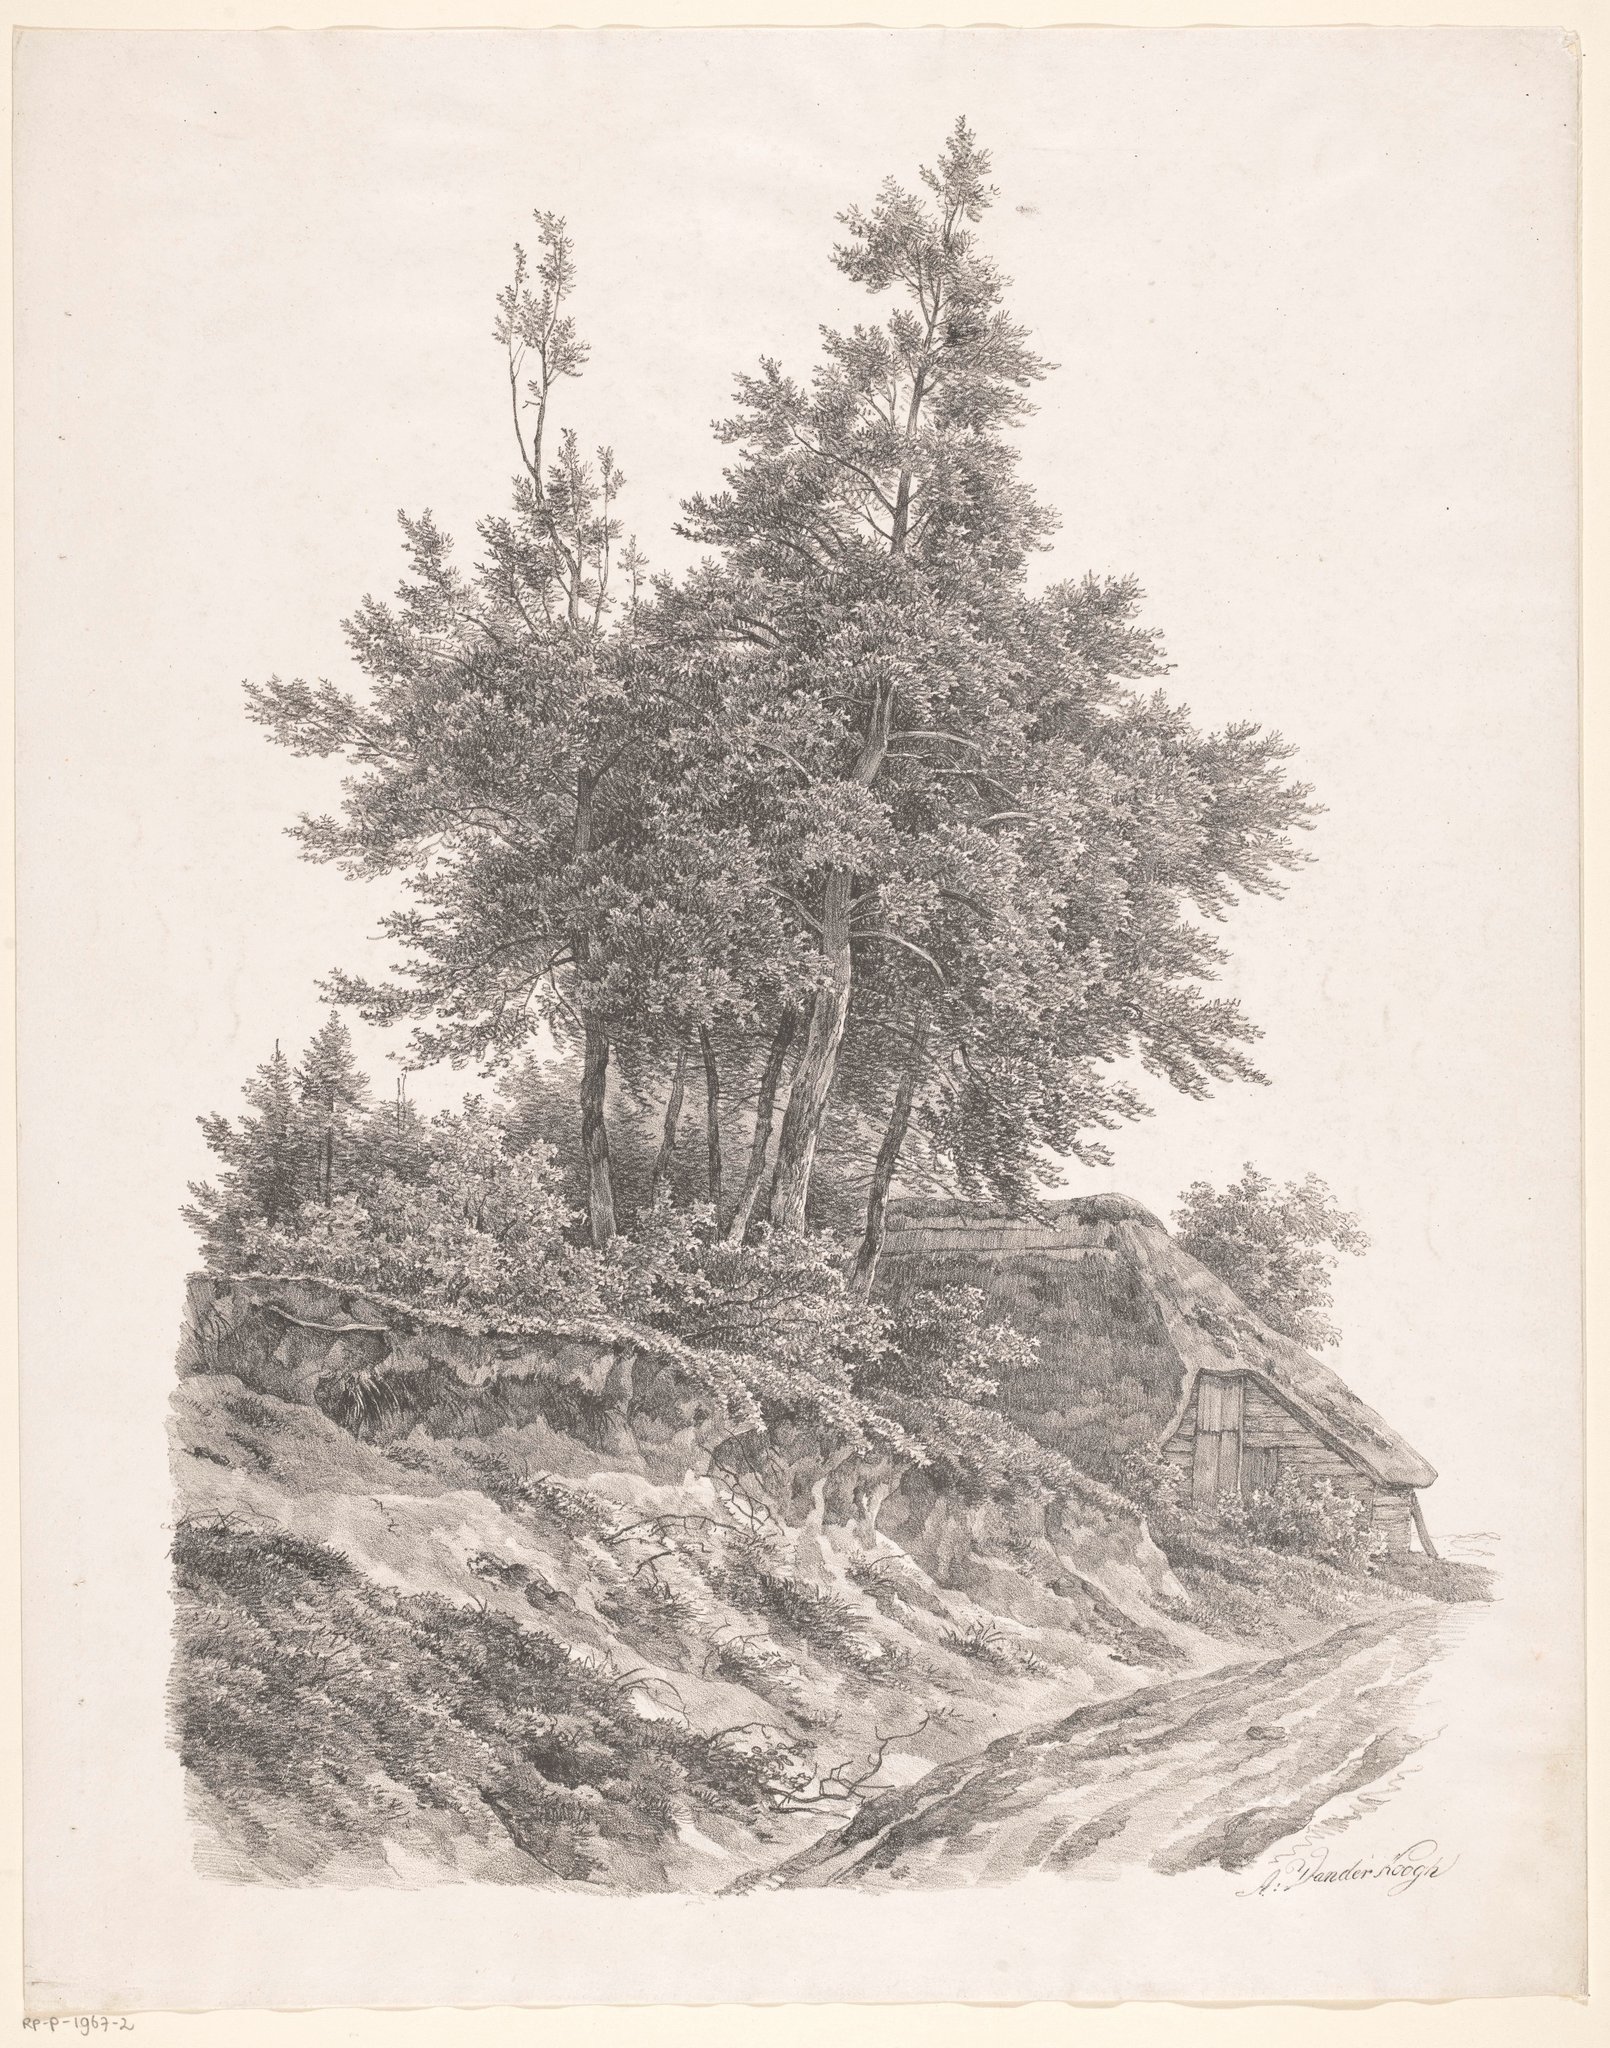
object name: print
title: Boomstudiën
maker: adrianus van der koogh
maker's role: draughtsman, print maker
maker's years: 1796-1831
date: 1826-1828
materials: paper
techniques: lithograph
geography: dordrecht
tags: road, path, groups of trees, farm (building)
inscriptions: collector's mark: Lugt 2228, collector's mark: Lugt 2760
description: In 1826 gaf Steuerwald & Comp een serie boomstudies uit van Adrianus van der Koogh, bedoeld voor het tekenonderwijs. In de collectie van het Rijksmuseum bevinden zich de omslag voor deze eerste bundel uit 1826 (RP-P-OB-28.980) en de titelprent voor een tweede bundel uit 1828 (RP-P-OB-68.274). In de literatuur wordt enkel de uitgave in 1826 genoemd. Zie: Kramm, 1859.